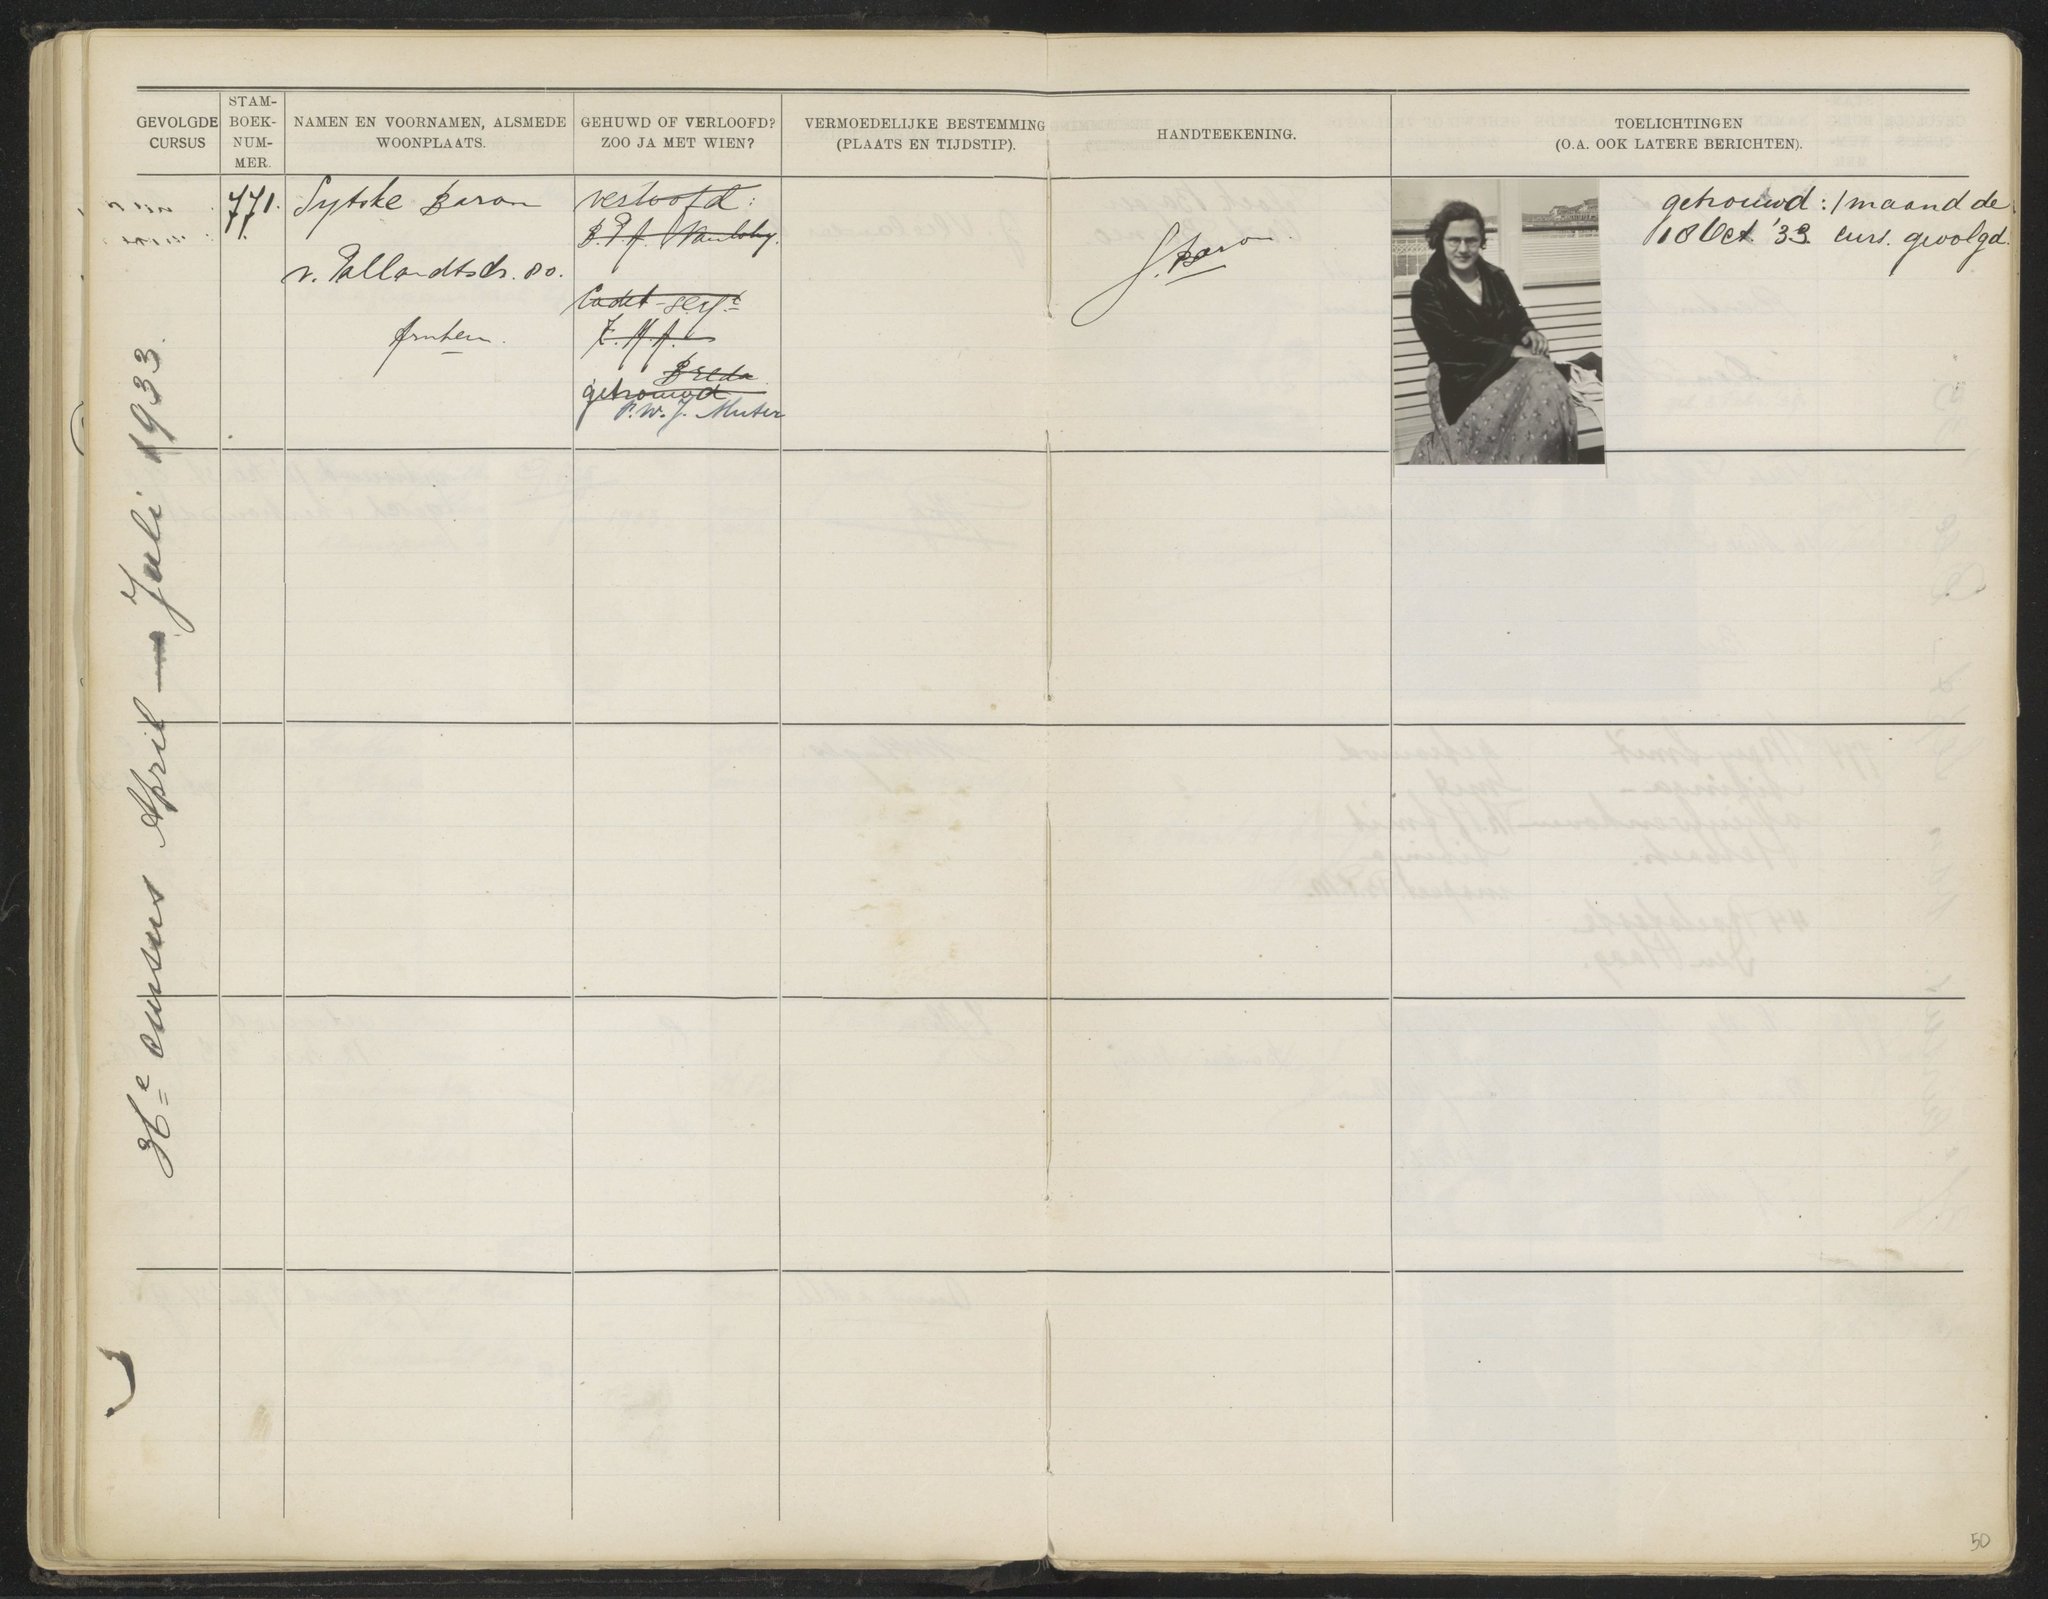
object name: photograph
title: Blad 50 uit Stamboek van de leerlingen der Koloniale School voor Meisjes en Vrouwen te 's-Gravenhage deel II (1930-1949)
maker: Anonymous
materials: paper, photographic support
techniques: photography, printing, writing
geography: the hague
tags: further education (+ pupil), further education, the hague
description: Twee pagina's met gegevens van een deelnemer aan de 36e driemaandelijkse cursus van 24 april tot juli 1933, stamboeknummer 771. Onderdeel van Stamboek van de leerlingen der Koloniale School voor Meisjes en Vrouwen te 's-Gravenhage deel II (1930-1949).